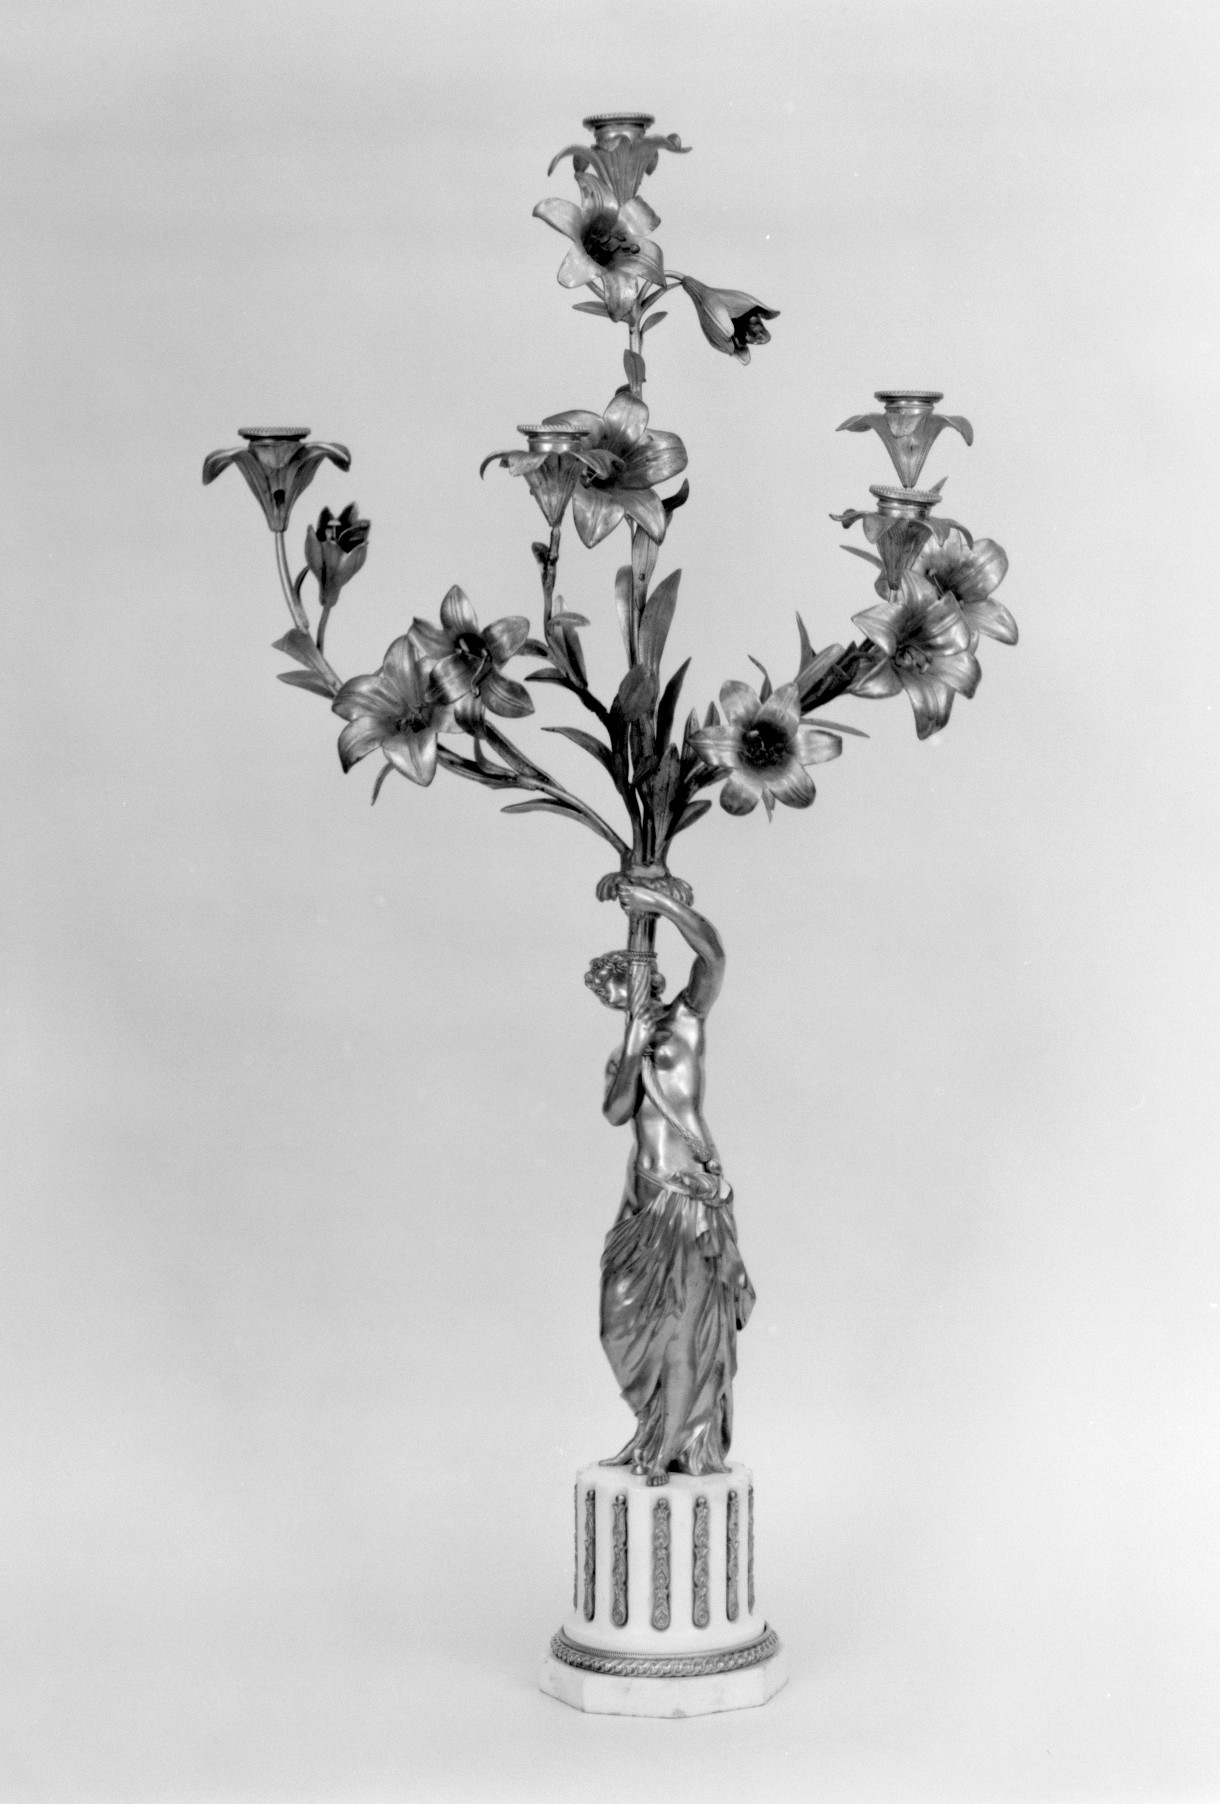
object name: candelabrum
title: Pair of candelabra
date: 1780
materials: gilt bronze, marble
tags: women,flowers